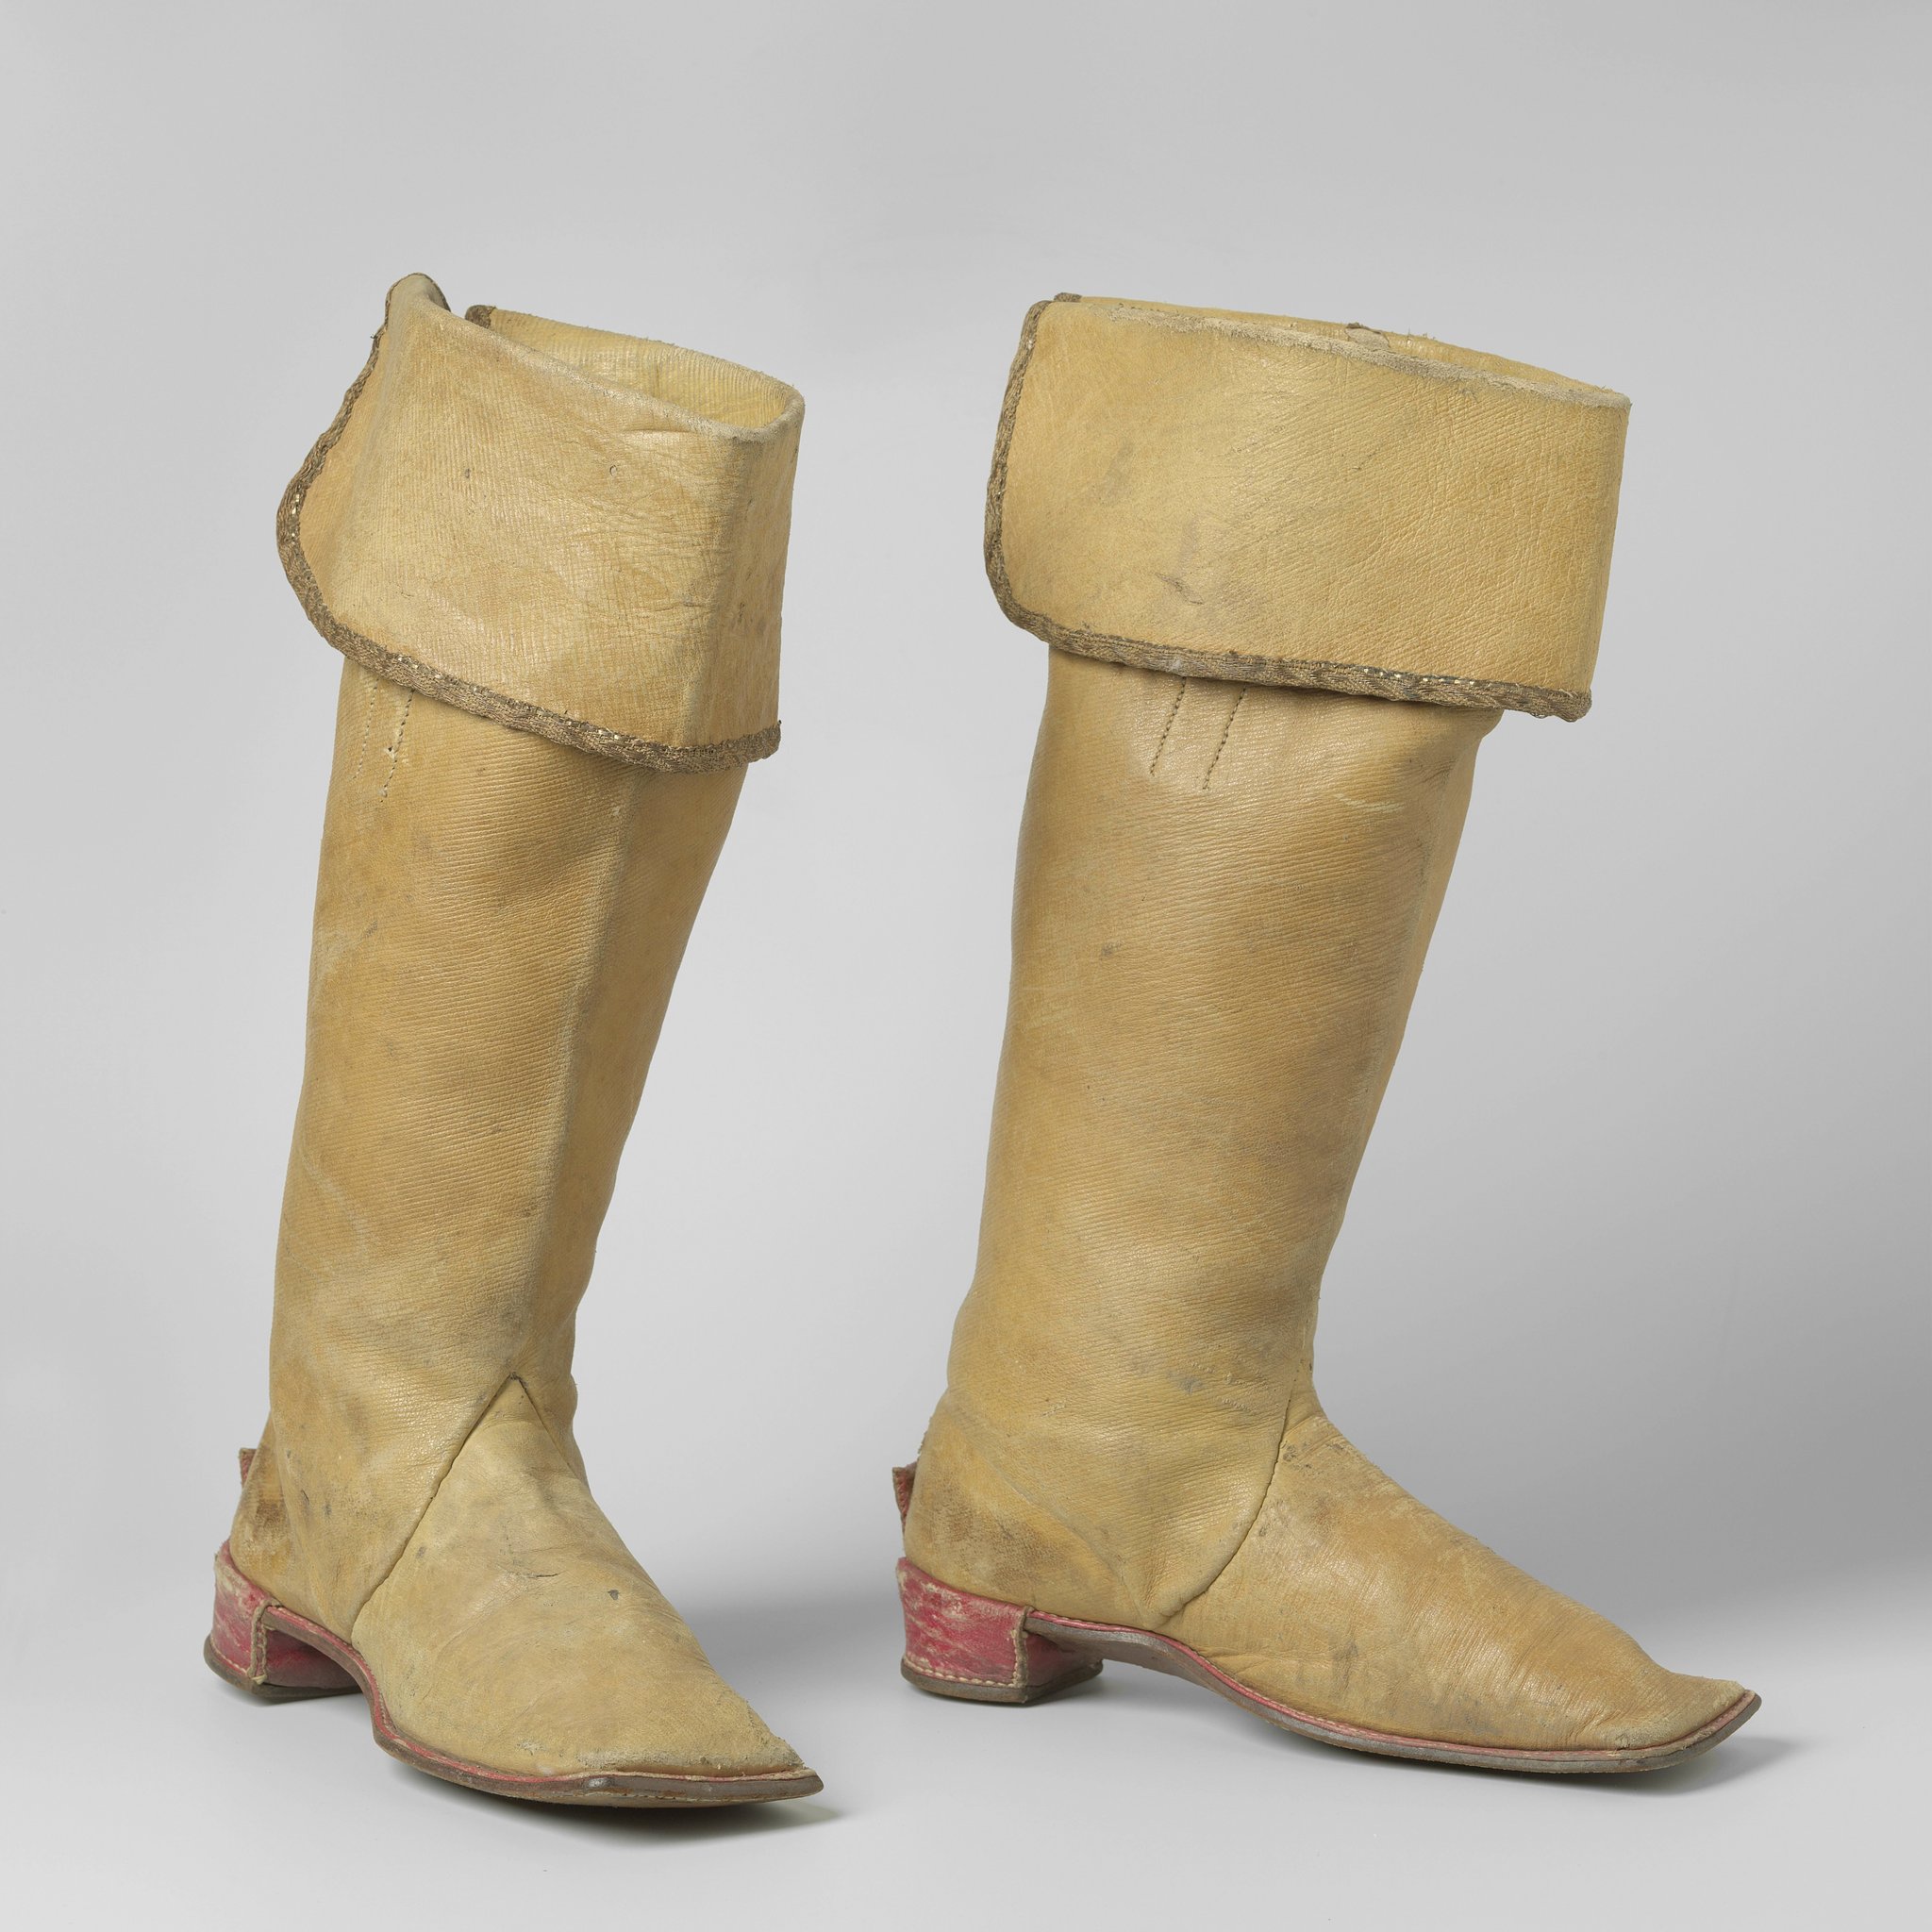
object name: maskerade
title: Kniehoge laars van geel runderleer, met een met goudgalon afgezette omslag bovenaan de schacht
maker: Anonymous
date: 1913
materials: gold galloon, cowhide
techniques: goudgalon, runderleer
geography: delft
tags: delft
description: Kniehoge laars van geel runderleer met een met goudgalon afgezette omslag bovenaan de schacht. De laars heeft een vierkante neus en een lage rechte hak. De zool, hak en naad middenachter zijn rood.